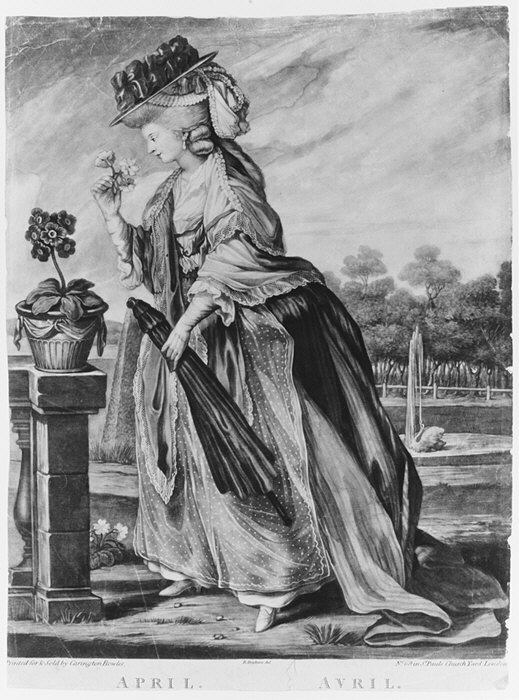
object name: print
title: April / Avril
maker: richard earlom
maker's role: engraver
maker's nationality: british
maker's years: 1743-1822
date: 1781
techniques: hand coloring, mezzotint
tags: women